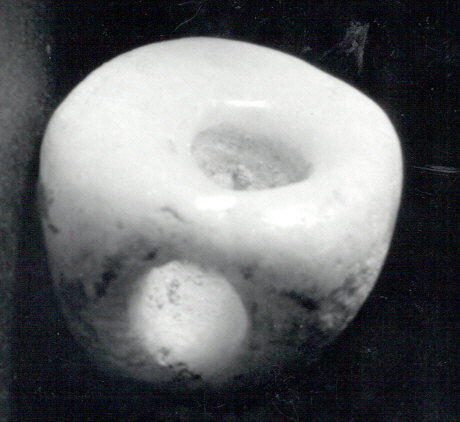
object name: pendant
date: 7000-5001 BCE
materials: limestone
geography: syria